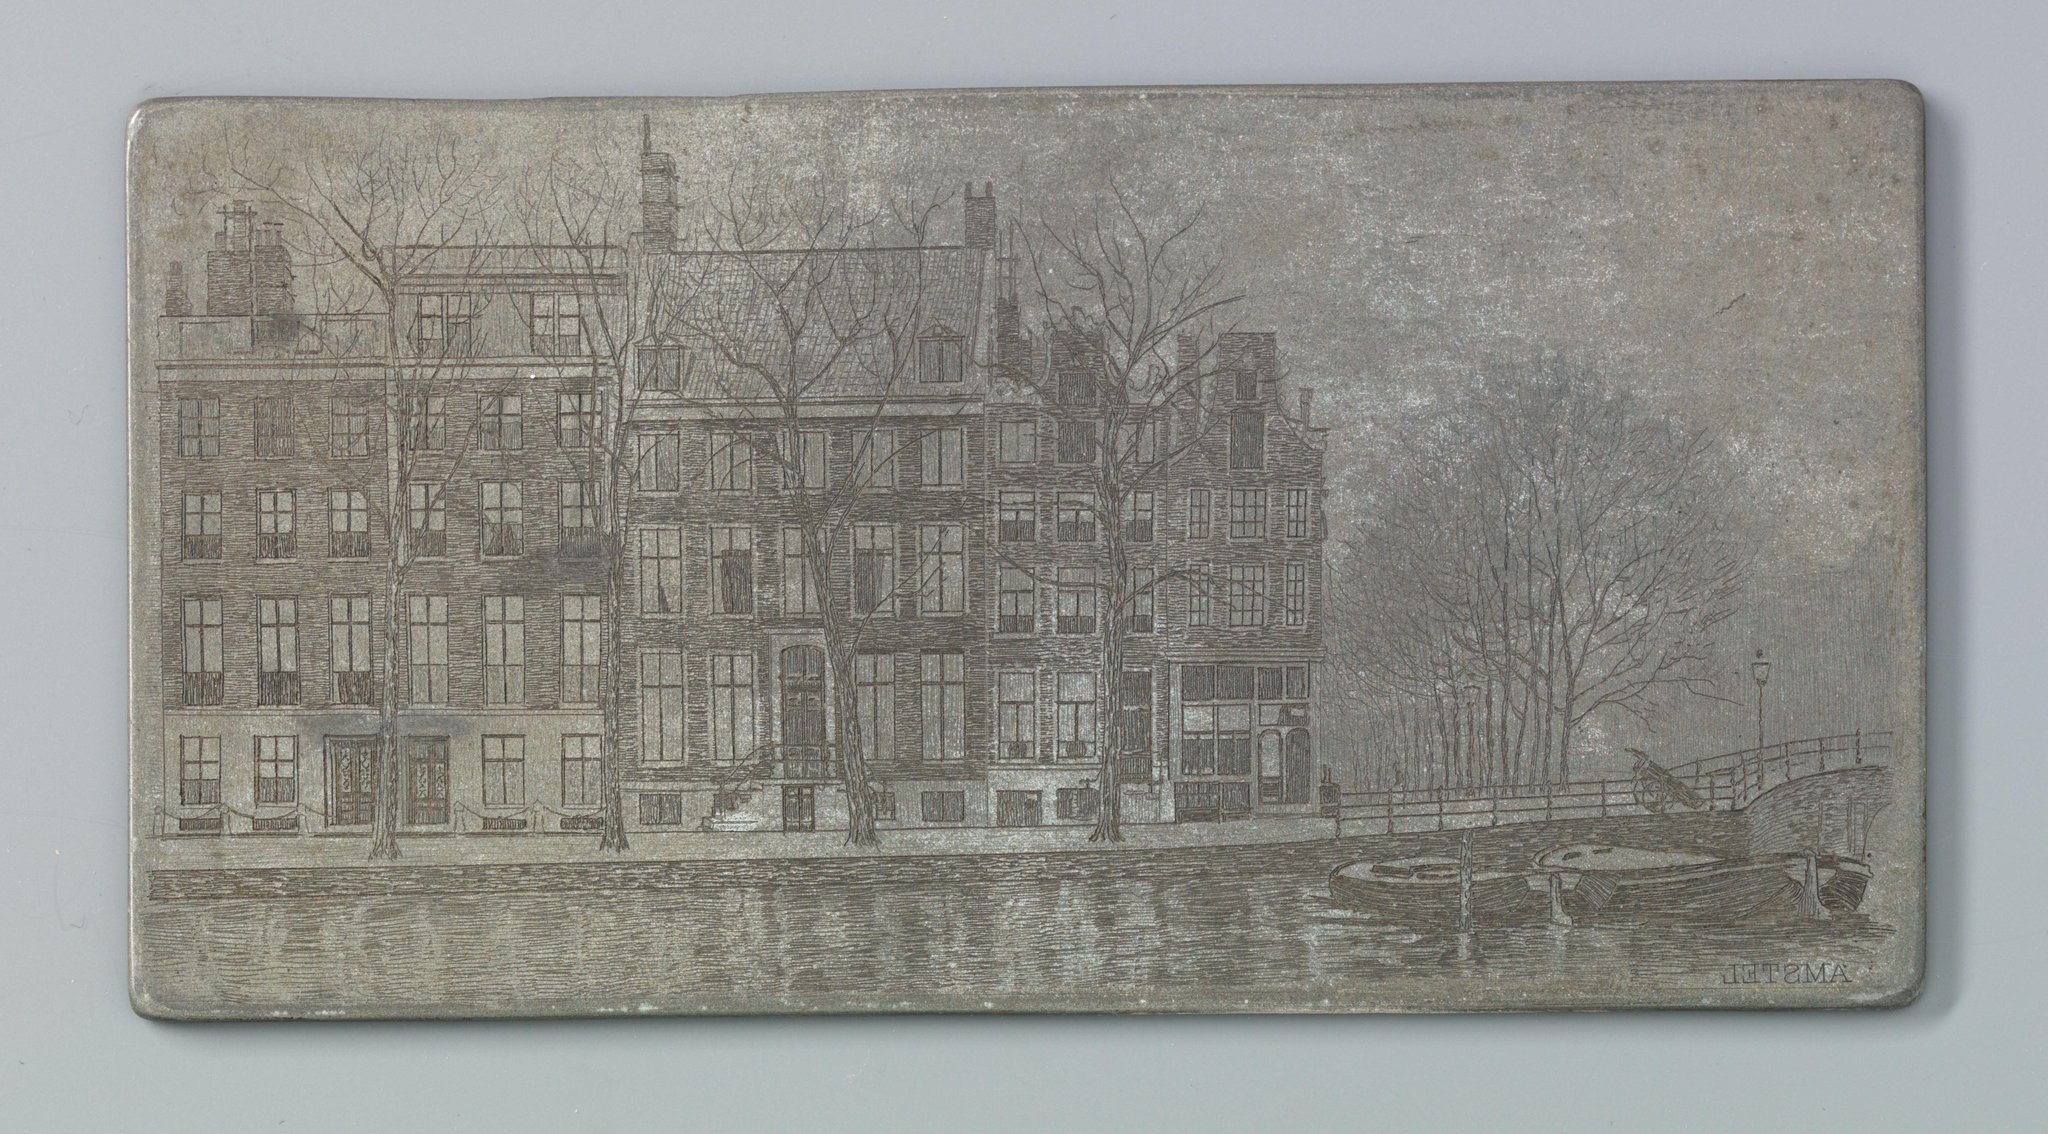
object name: zinkplaat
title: De Amstel in Amsterdam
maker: Anonymous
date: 1860-1920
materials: zinc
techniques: etching